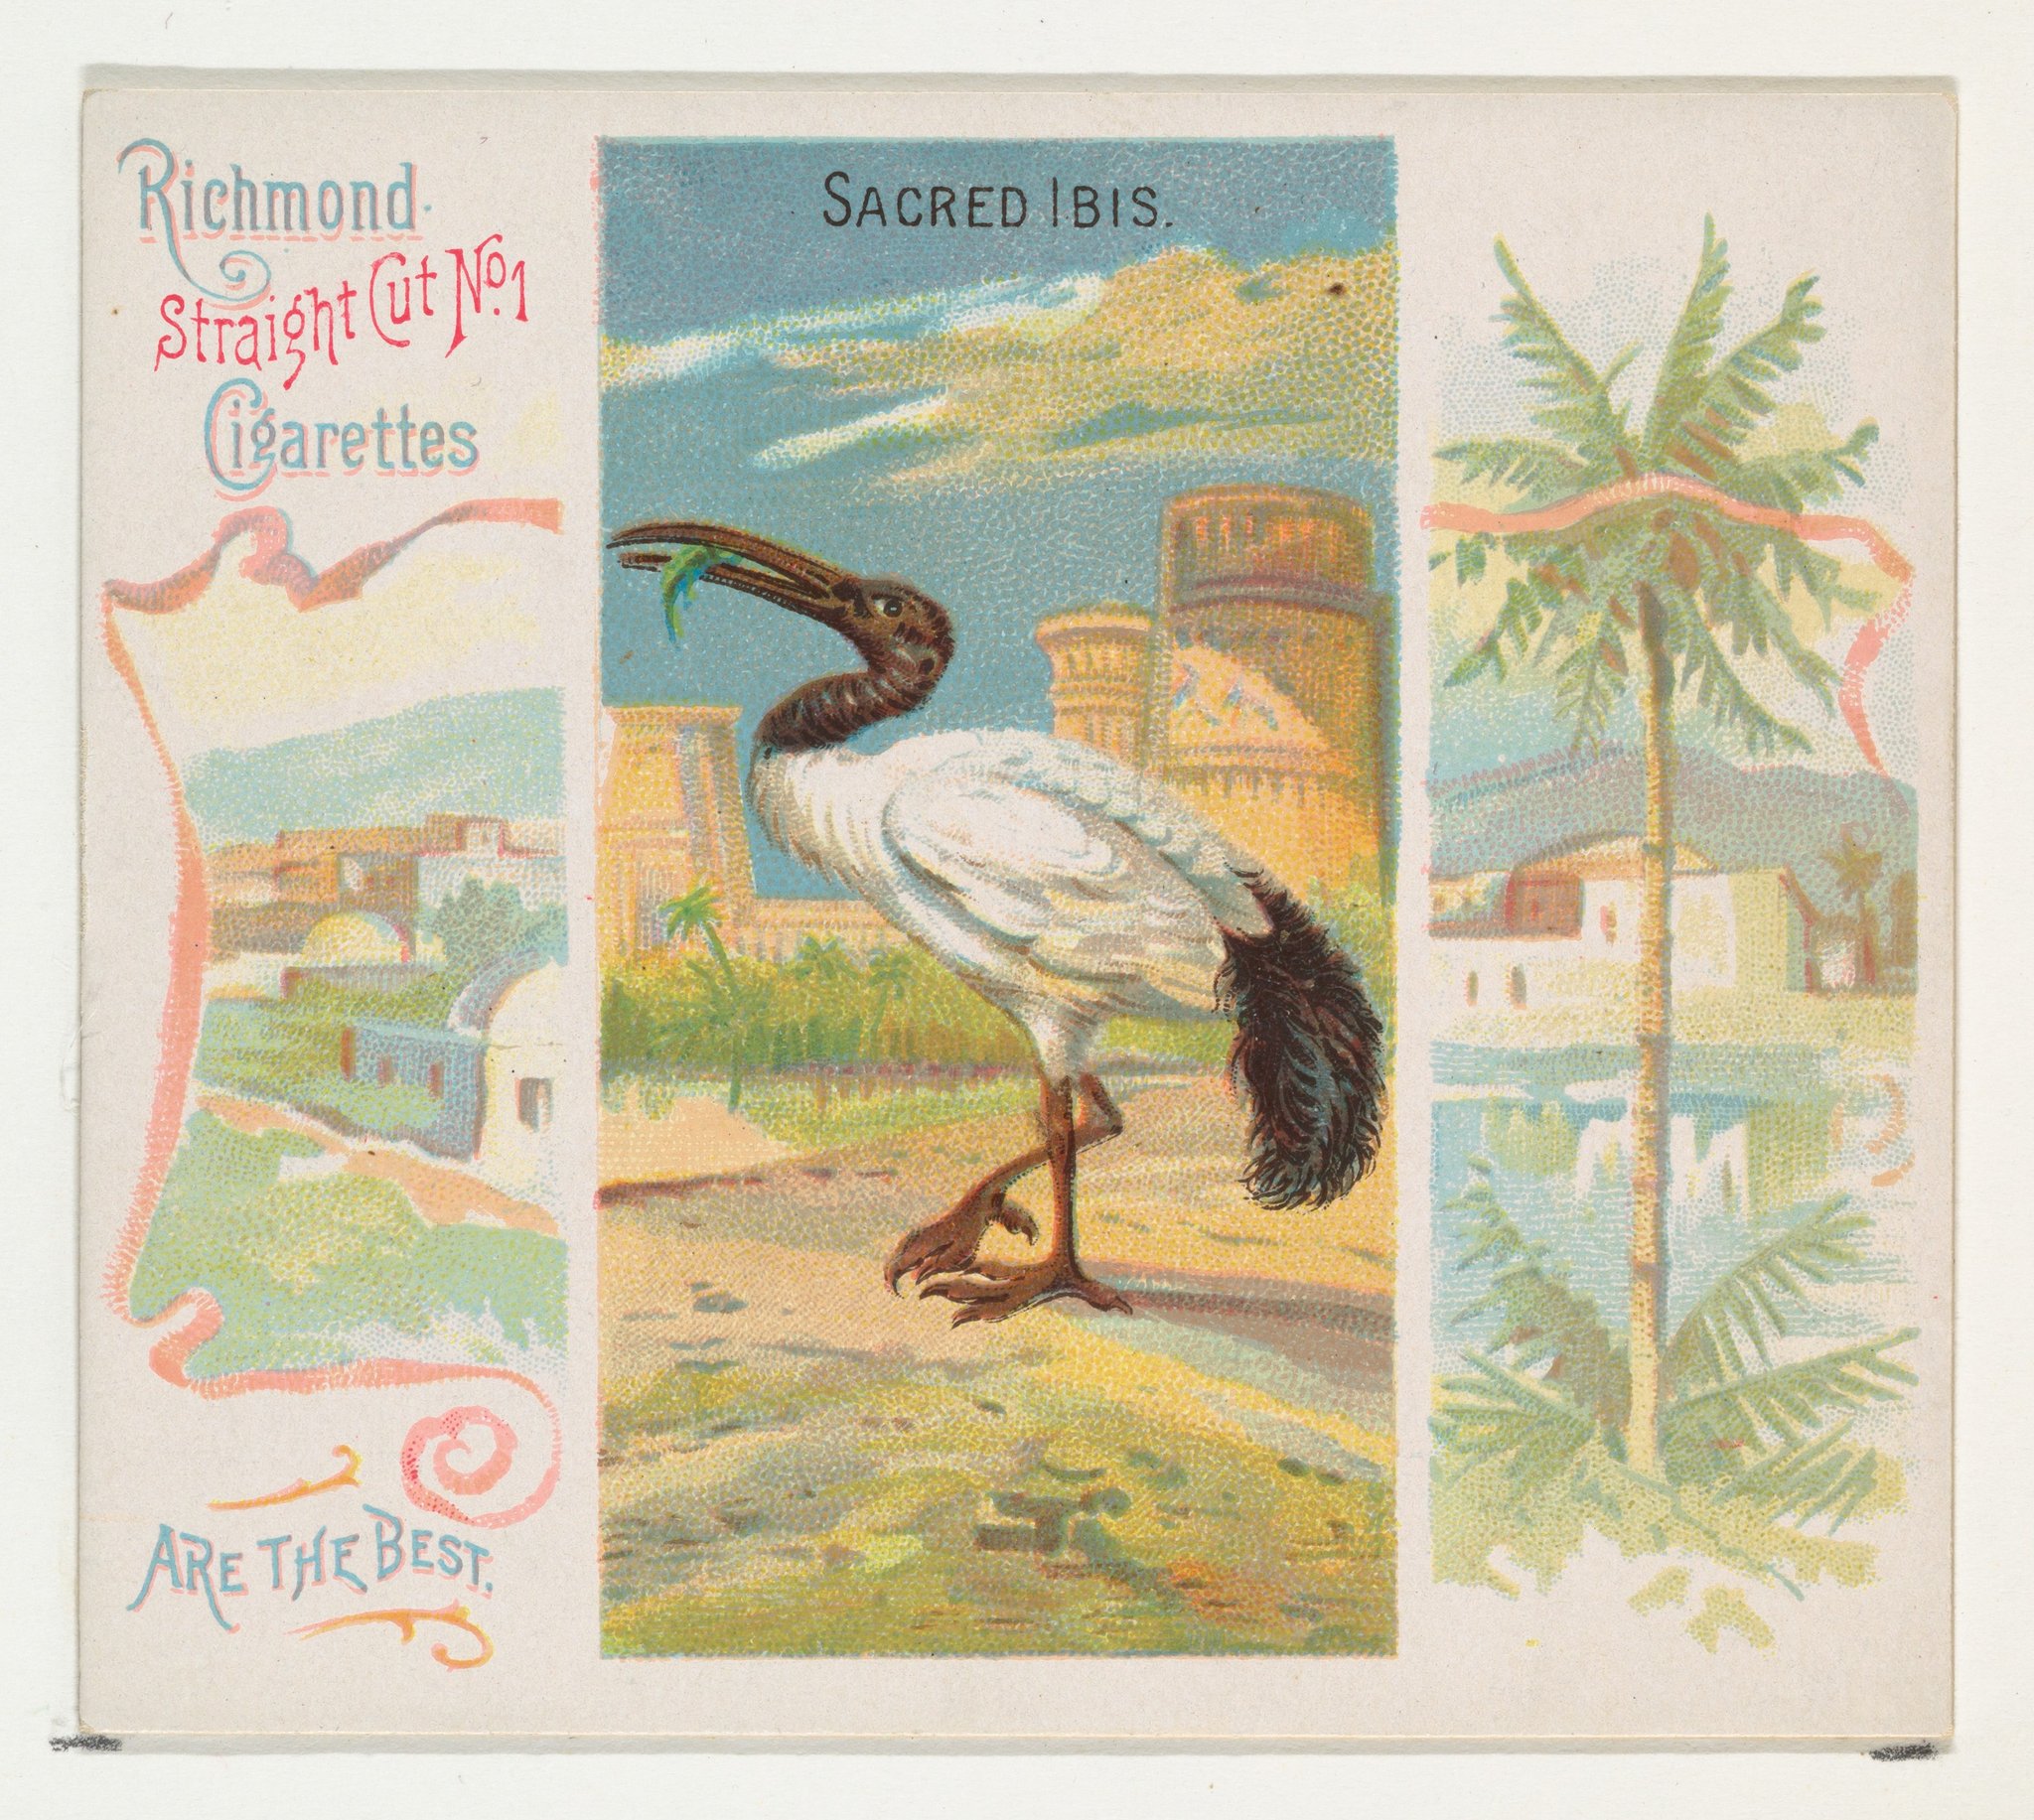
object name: print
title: Sacred Ibis, from Birds of the Tropics series (N38) for Allen & Ginter Cigarettes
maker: allen & ginter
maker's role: publisher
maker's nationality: american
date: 1889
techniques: color lithograph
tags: birds